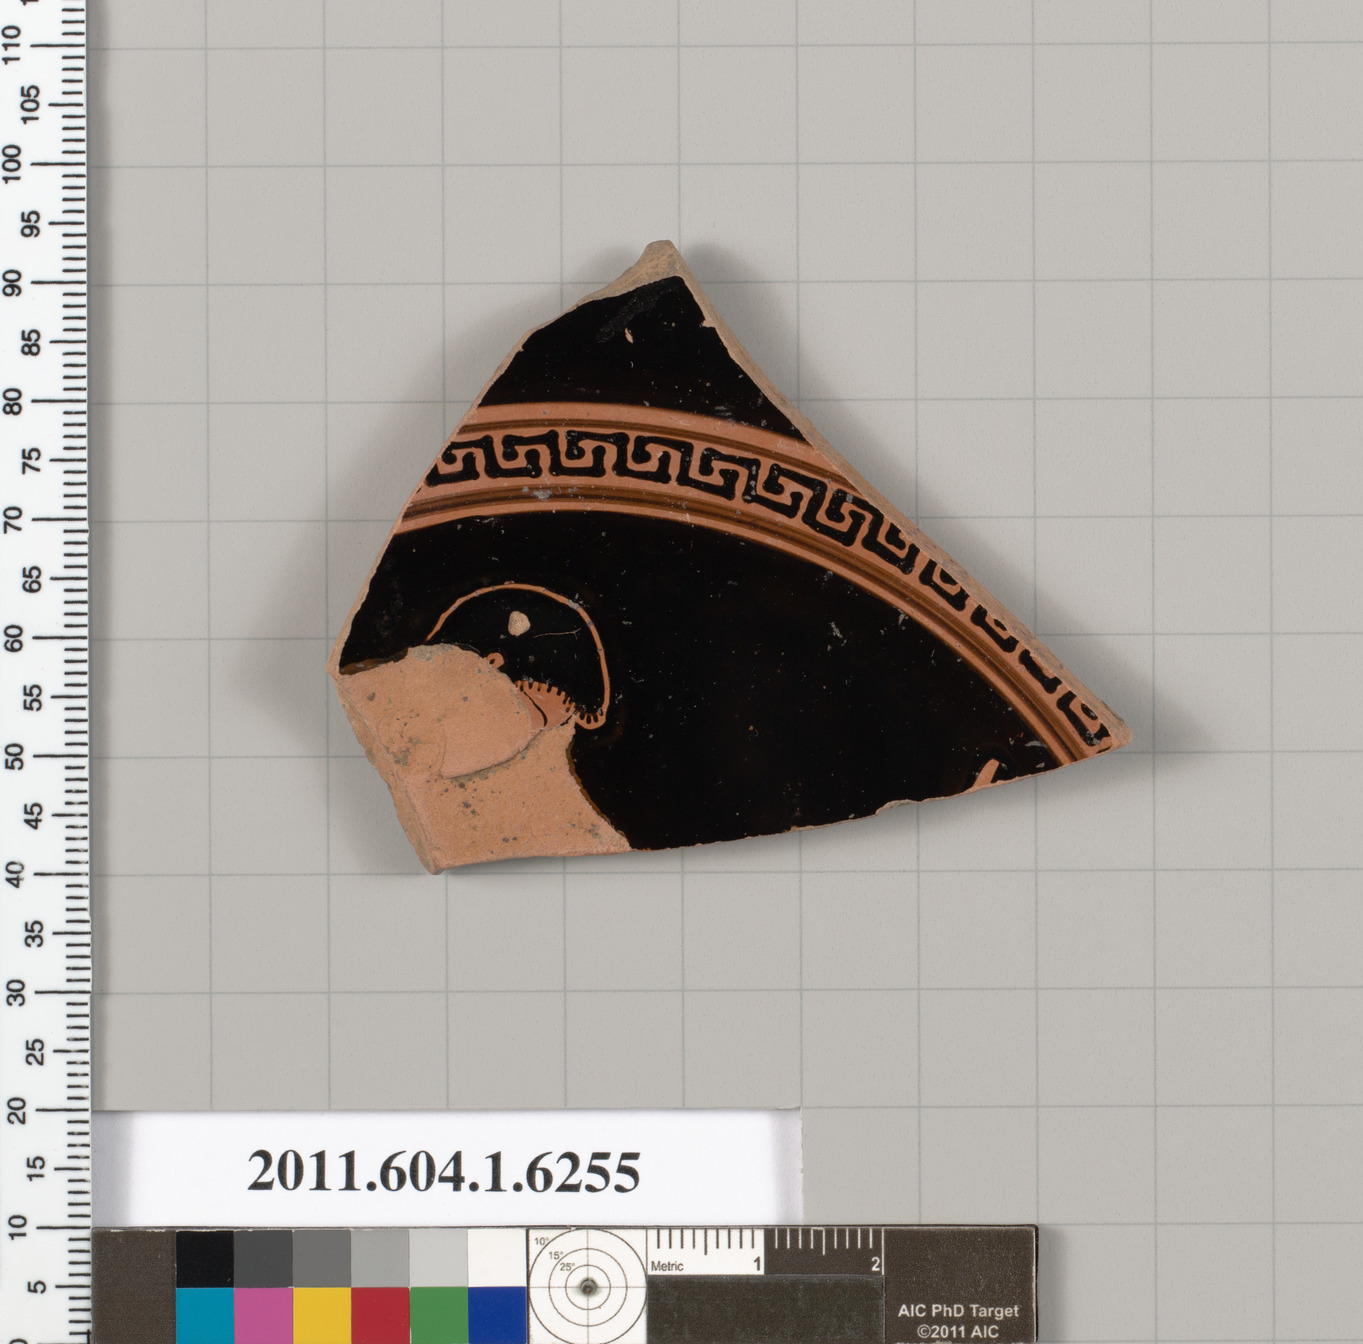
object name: kylix fragment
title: Terracotta fragment of a kylix (drinking cup)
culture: greek, attic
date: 500-480 BCE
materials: terracotta